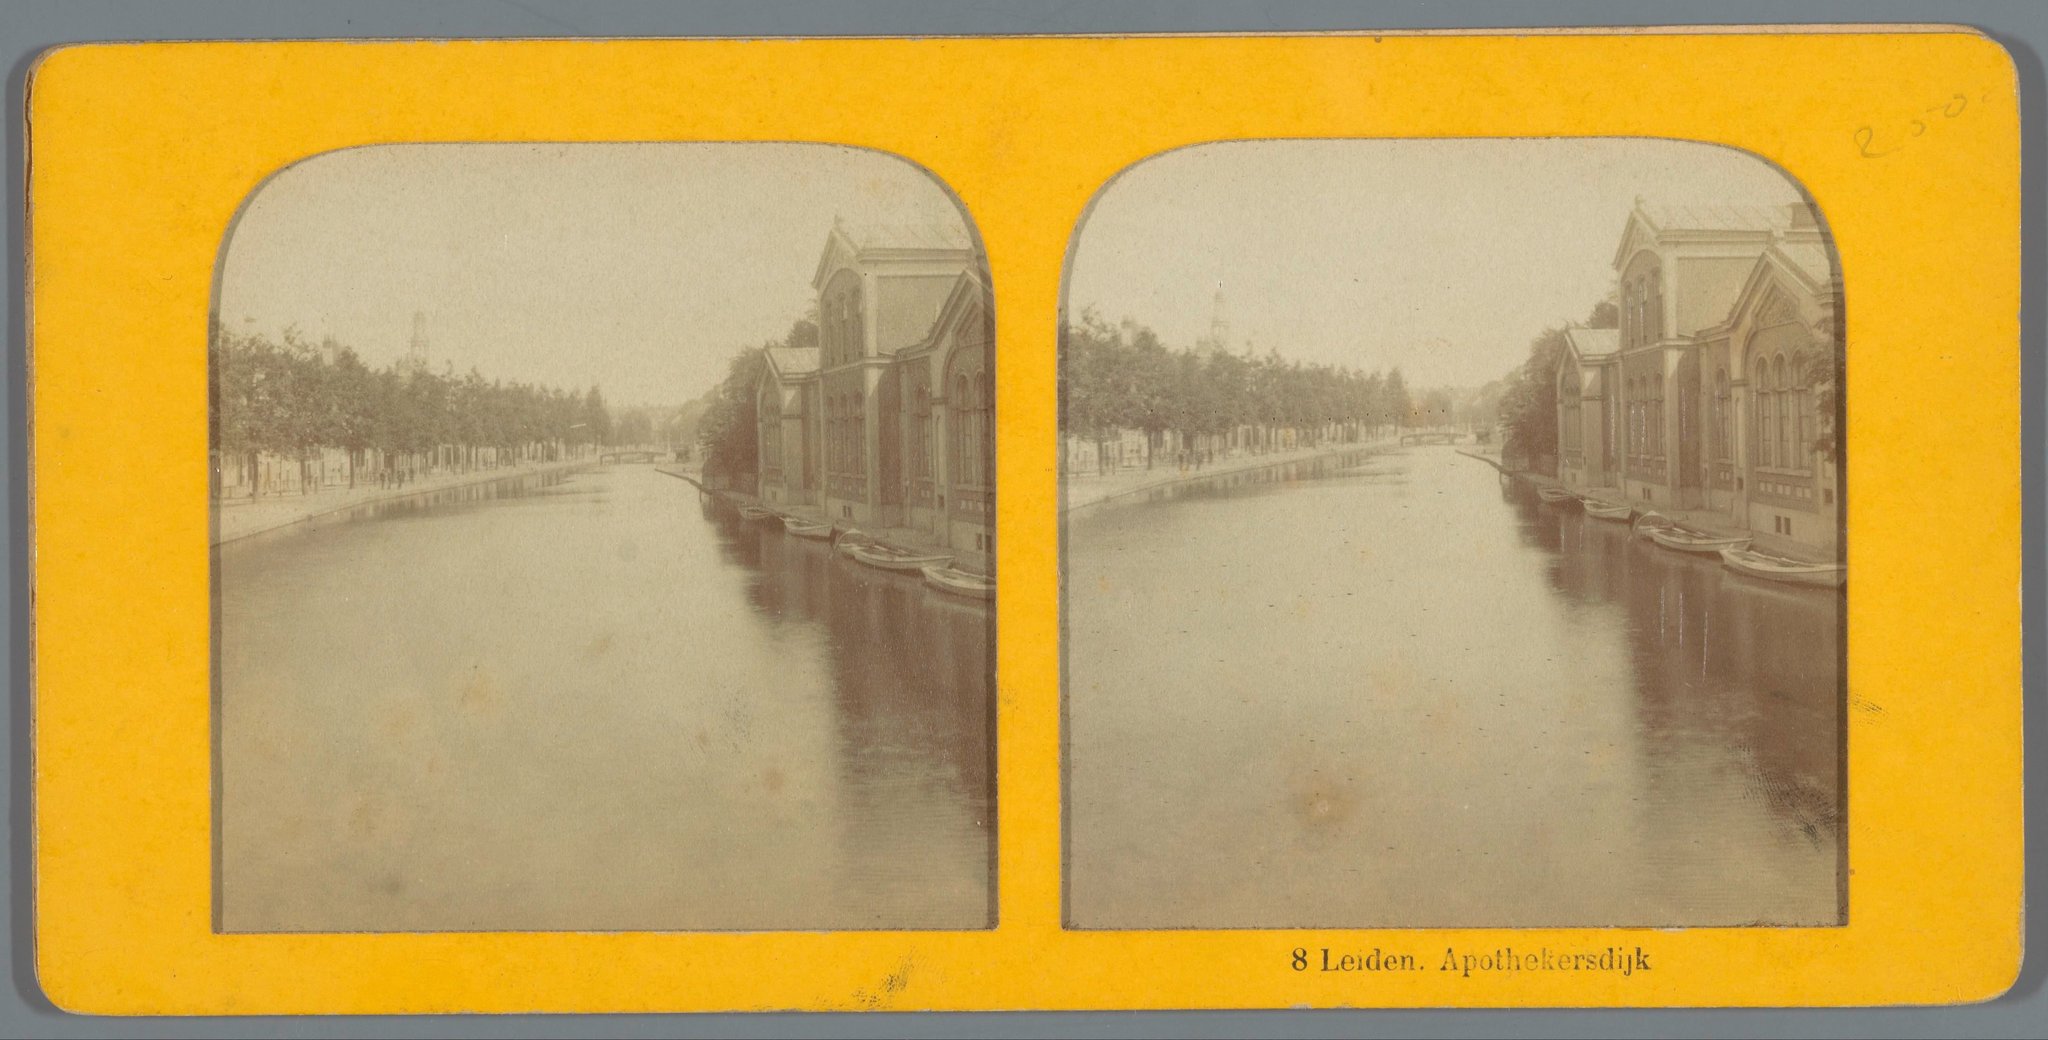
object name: tissue stereograph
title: Leiden. Apothekersdijk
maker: Anonymous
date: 1855-1875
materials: cardboard, paper, photographic support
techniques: albumen print, cutting, hand coloring, perforating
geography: leiden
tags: canals, waters (in city), leiden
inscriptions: number: ‘8’, number: ‘9’